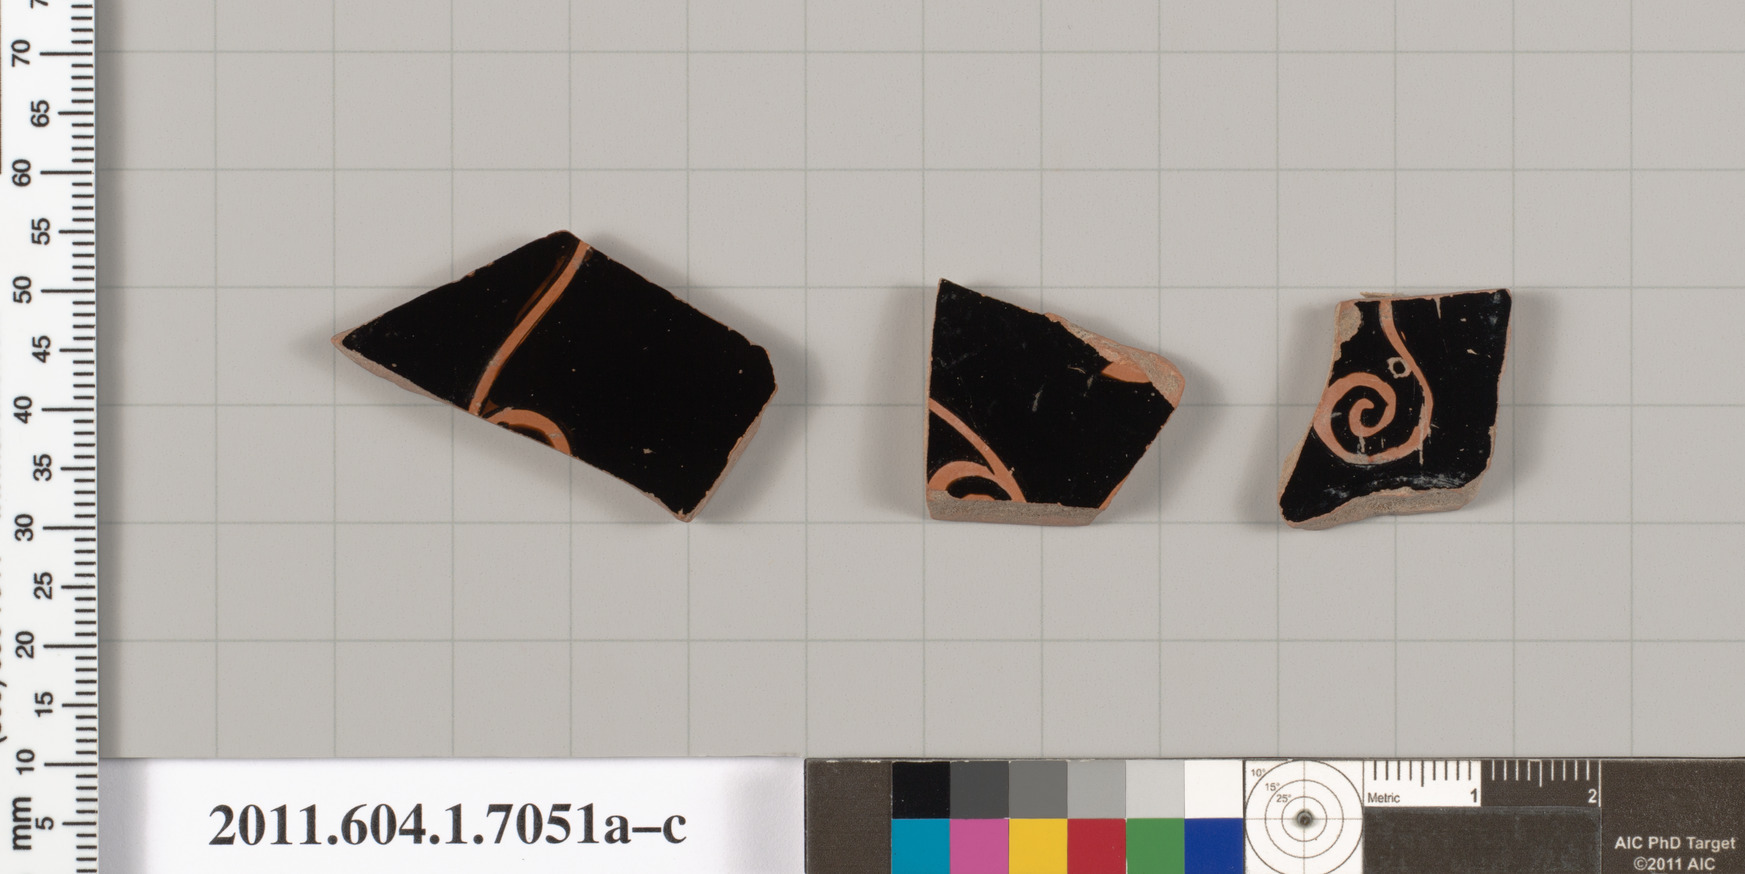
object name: kylix fragment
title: Terracotta fragments of kylikes (drinking cups)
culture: greek, attic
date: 500-480 BCE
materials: terracotta